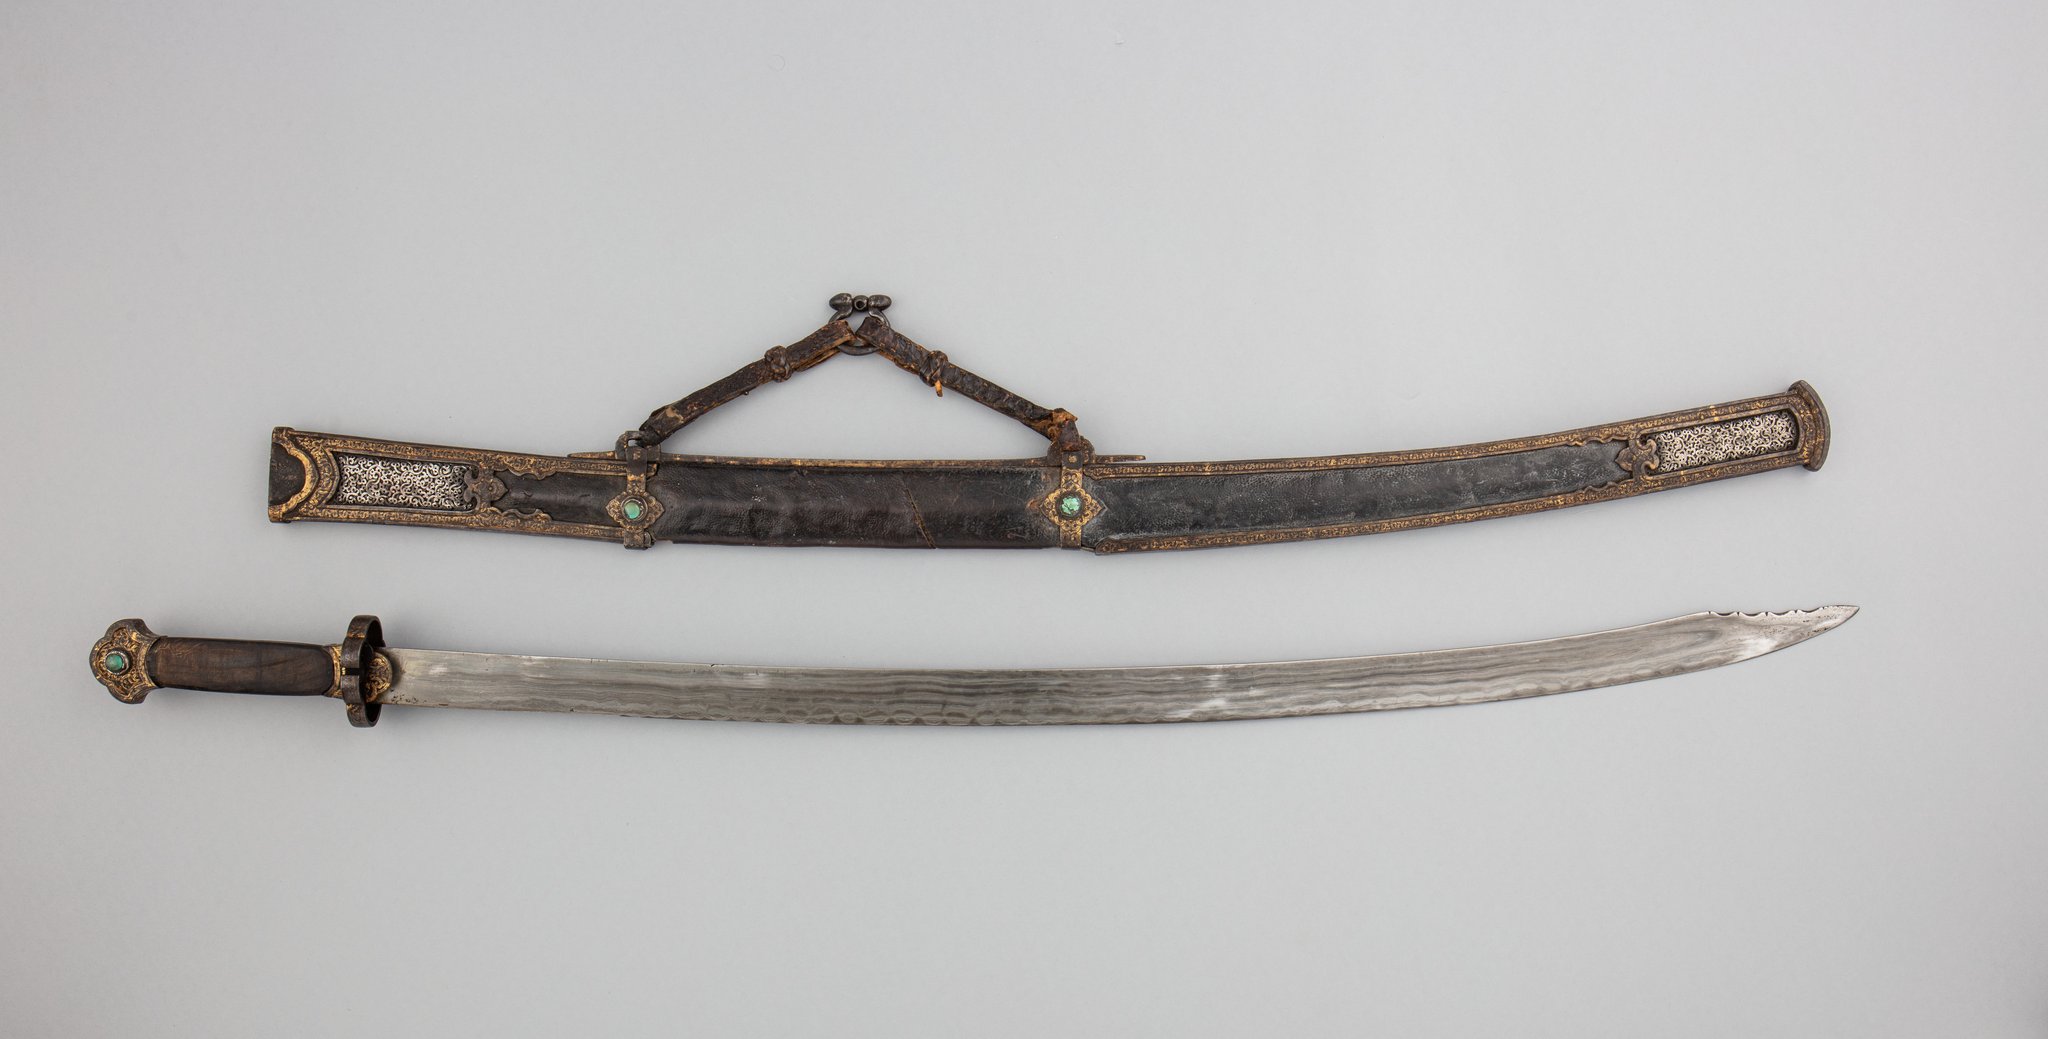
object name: saber with scabbard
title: Saber and Scabbard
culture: sino-tibetan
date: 1601-1800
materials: gold, leather, silver, steel, wood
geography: china